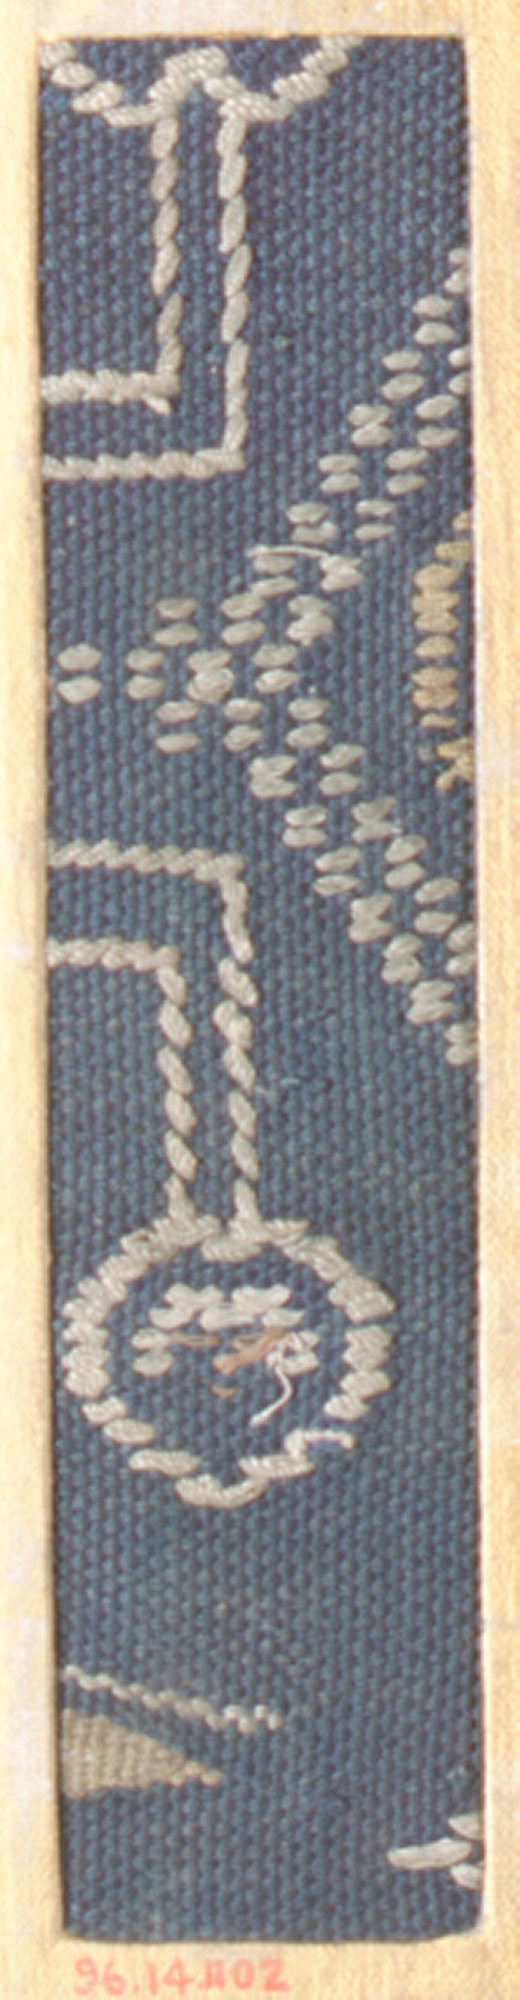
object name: piece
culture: japanese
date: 1701-1900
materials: silk